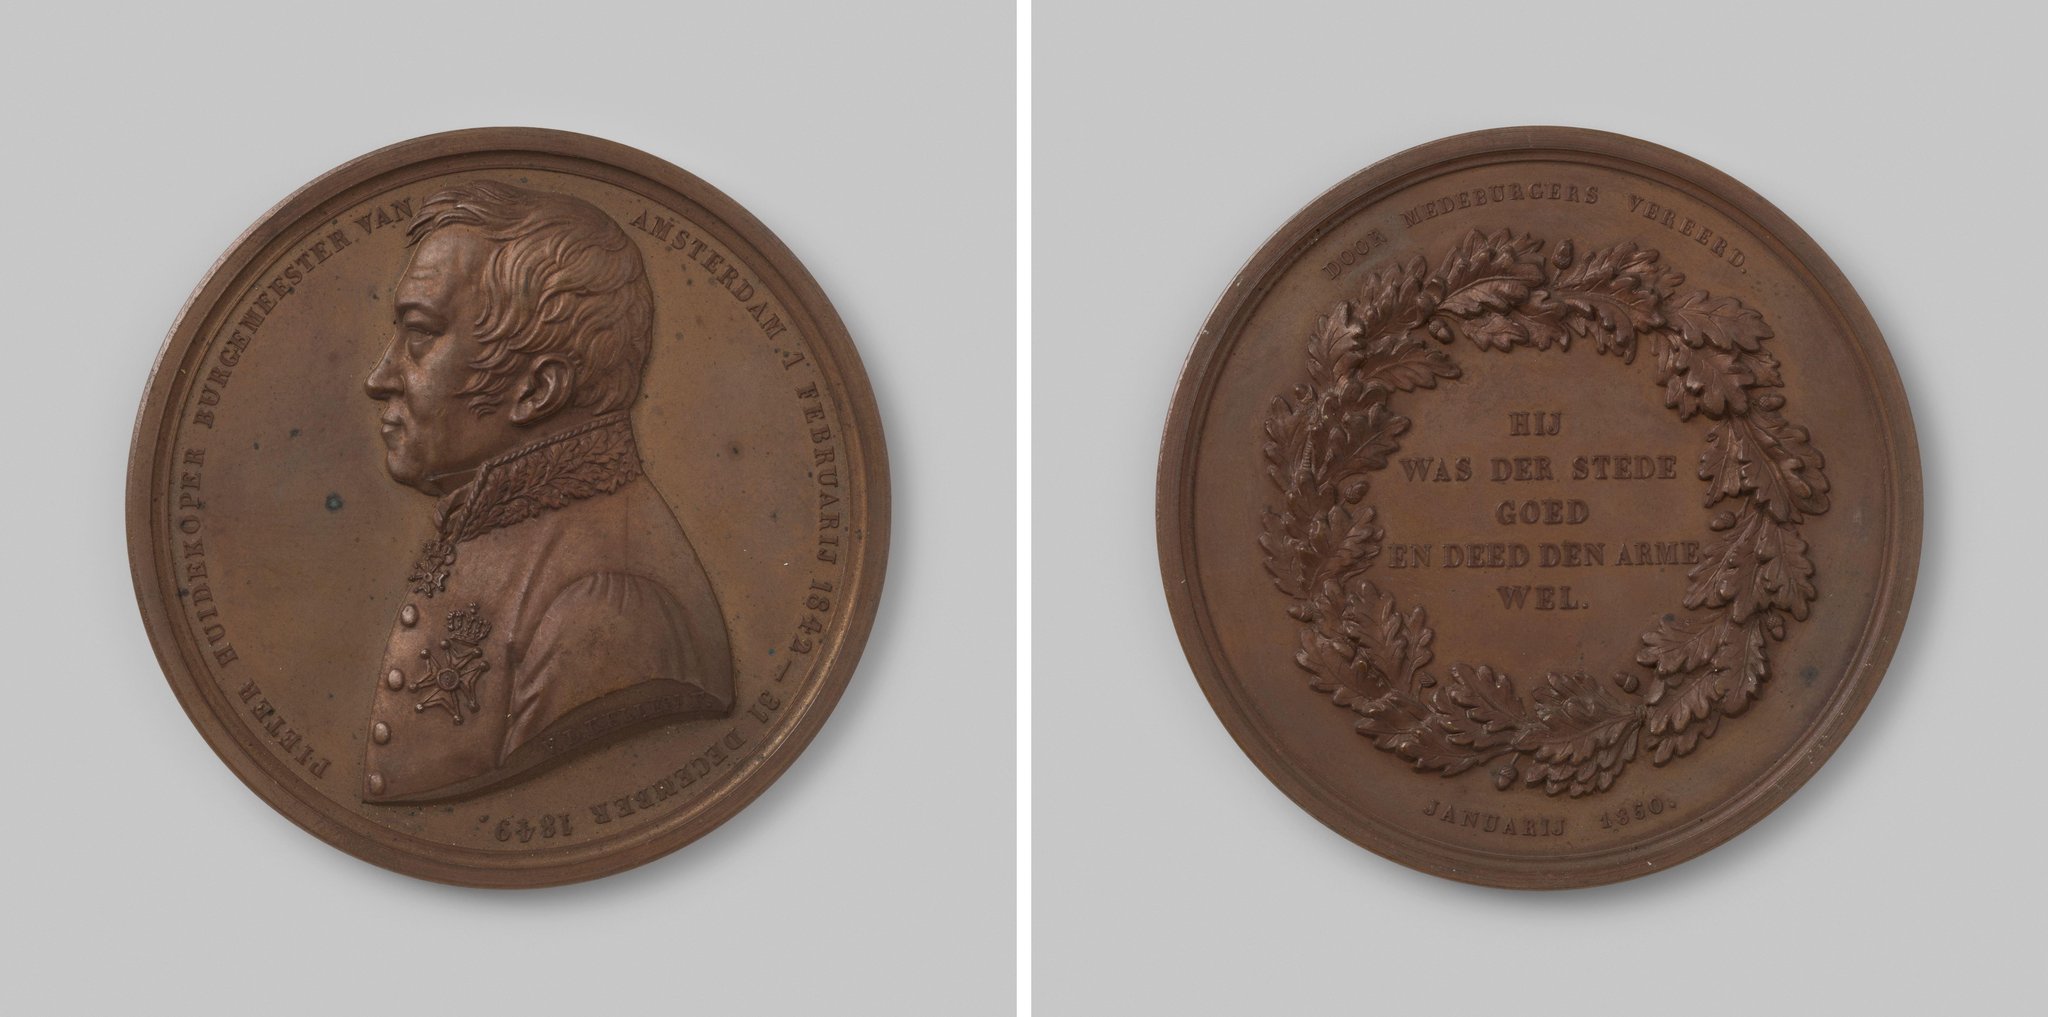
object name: honorary medal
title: Pieter Huidekoper, burgemeester van Amsterdam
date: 1850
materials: bronze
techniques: striking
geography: utrecht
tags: amsterdam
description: Uitgegeven in januari 1850 ter gelegenheid van het afscheid van Huidekoper als burgemeester van Amsterdam op 31 december 1849.